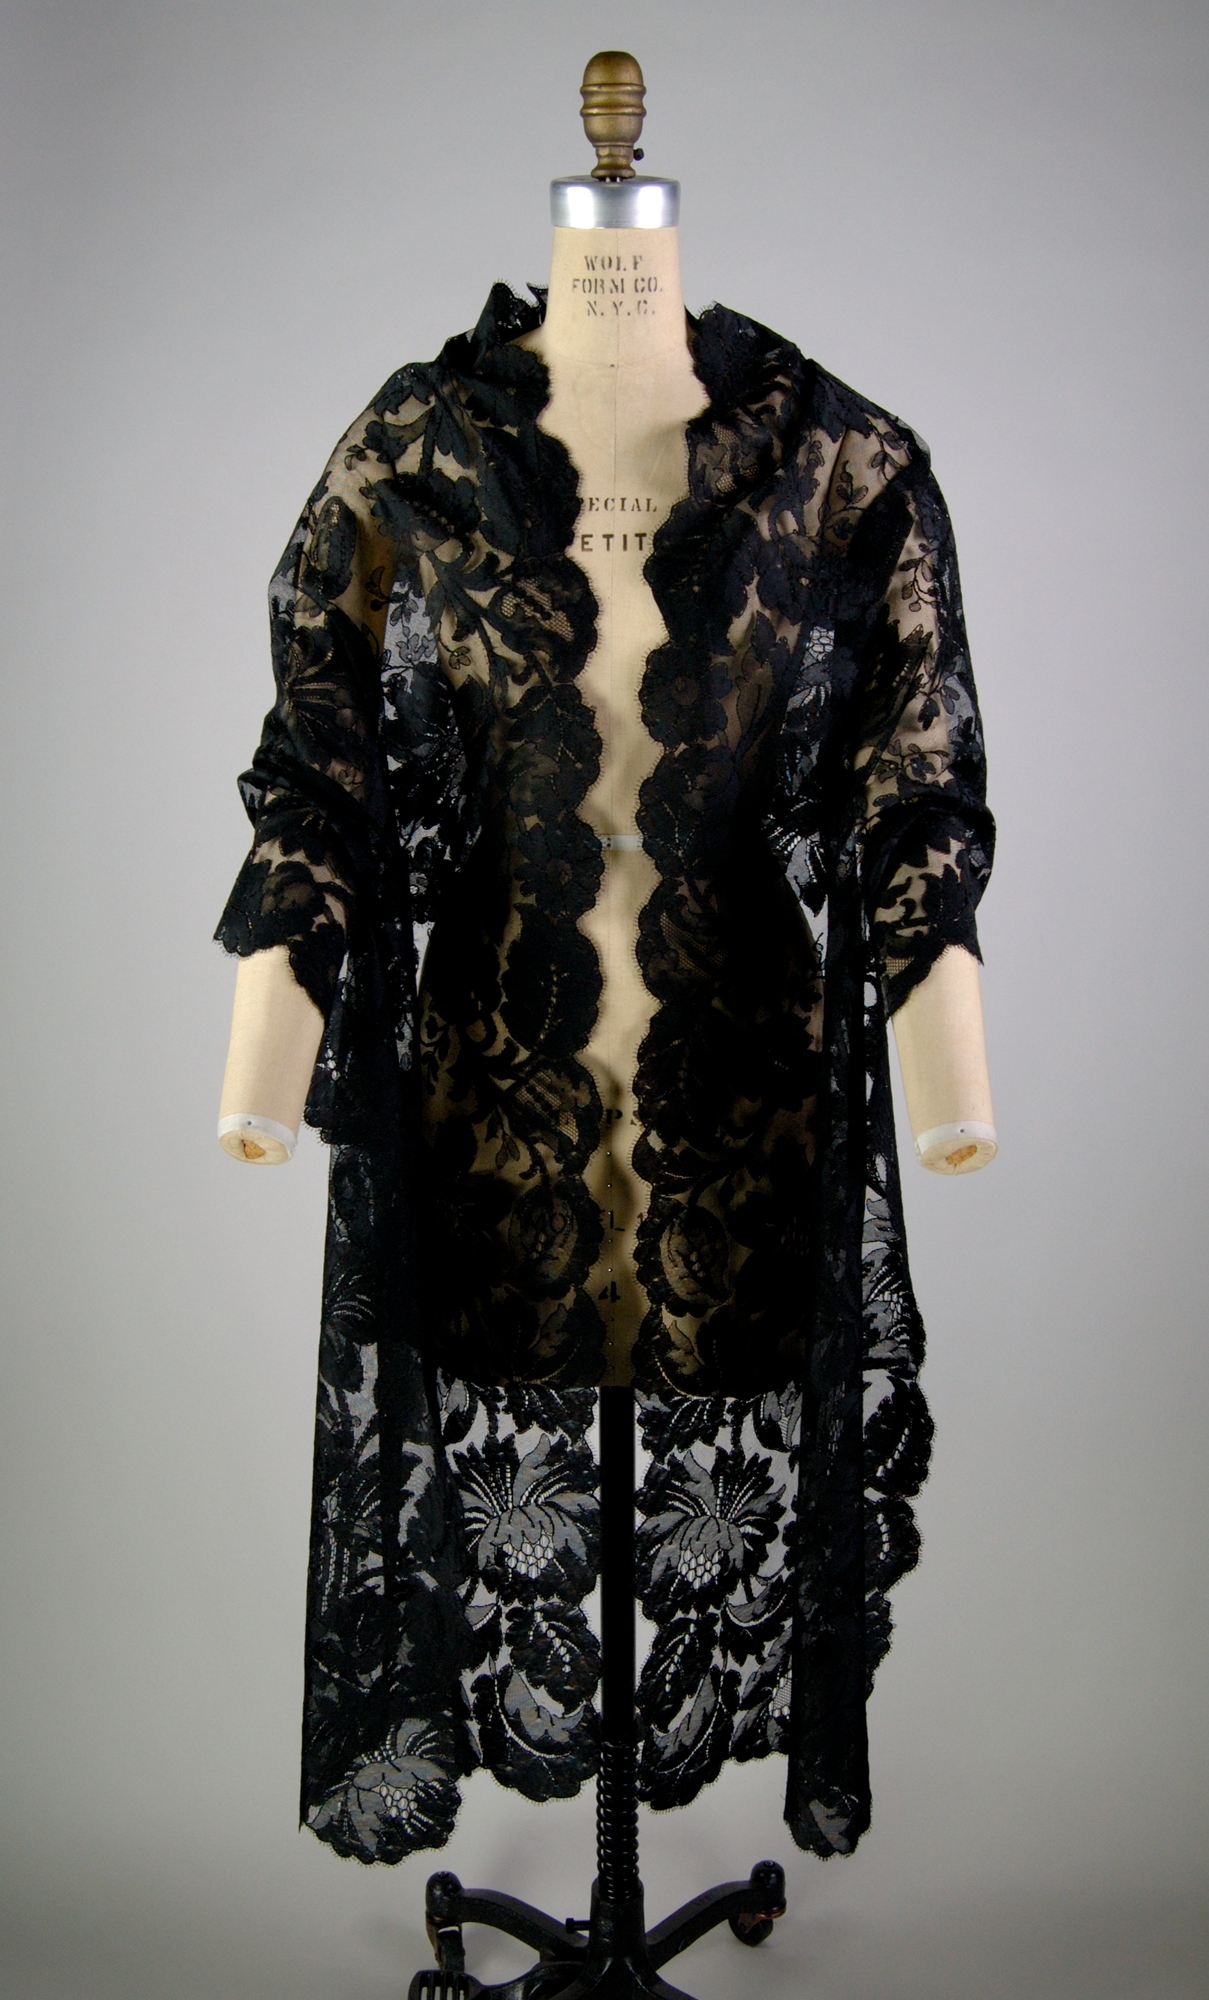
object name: stole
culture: spanish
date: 1876-1900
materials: silk